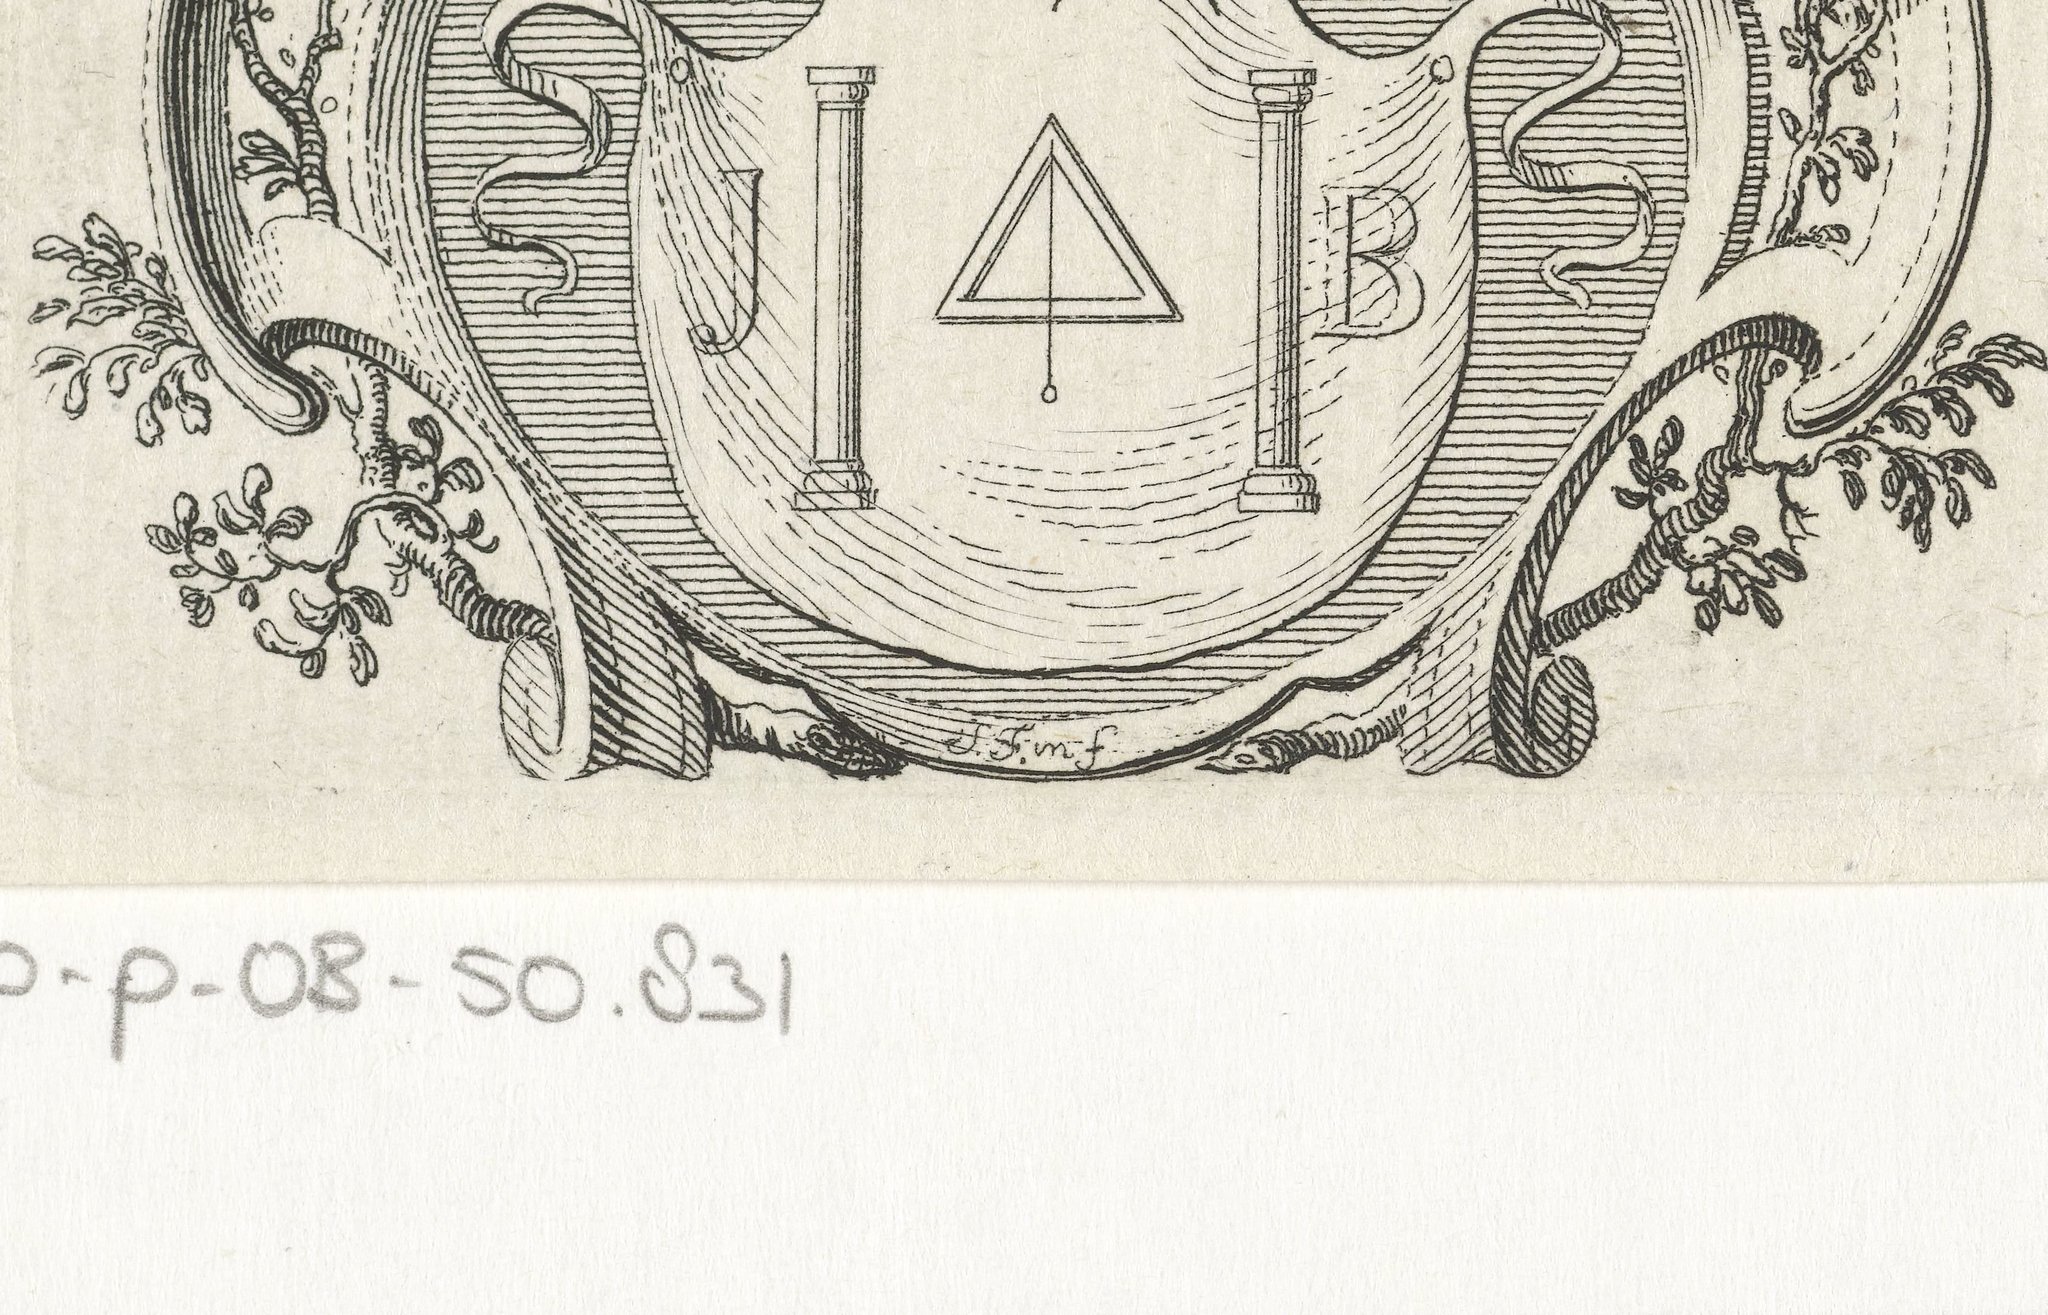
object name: print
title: Vignet met pilaren en meetinstrumenten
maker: simon fokke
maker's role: draughtsman, print maker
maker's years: 1712-1784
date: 1722-1784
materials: paper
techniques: etching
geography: amsterdam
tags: measuring-instruments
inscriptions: collector's mark: Lugt 240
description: Vignet met tussen de initialen J en B de beeltenis van twee pilaren en een meetdriehoek. Bovenin zijn een winkelhaak en een passer afgebeeld.